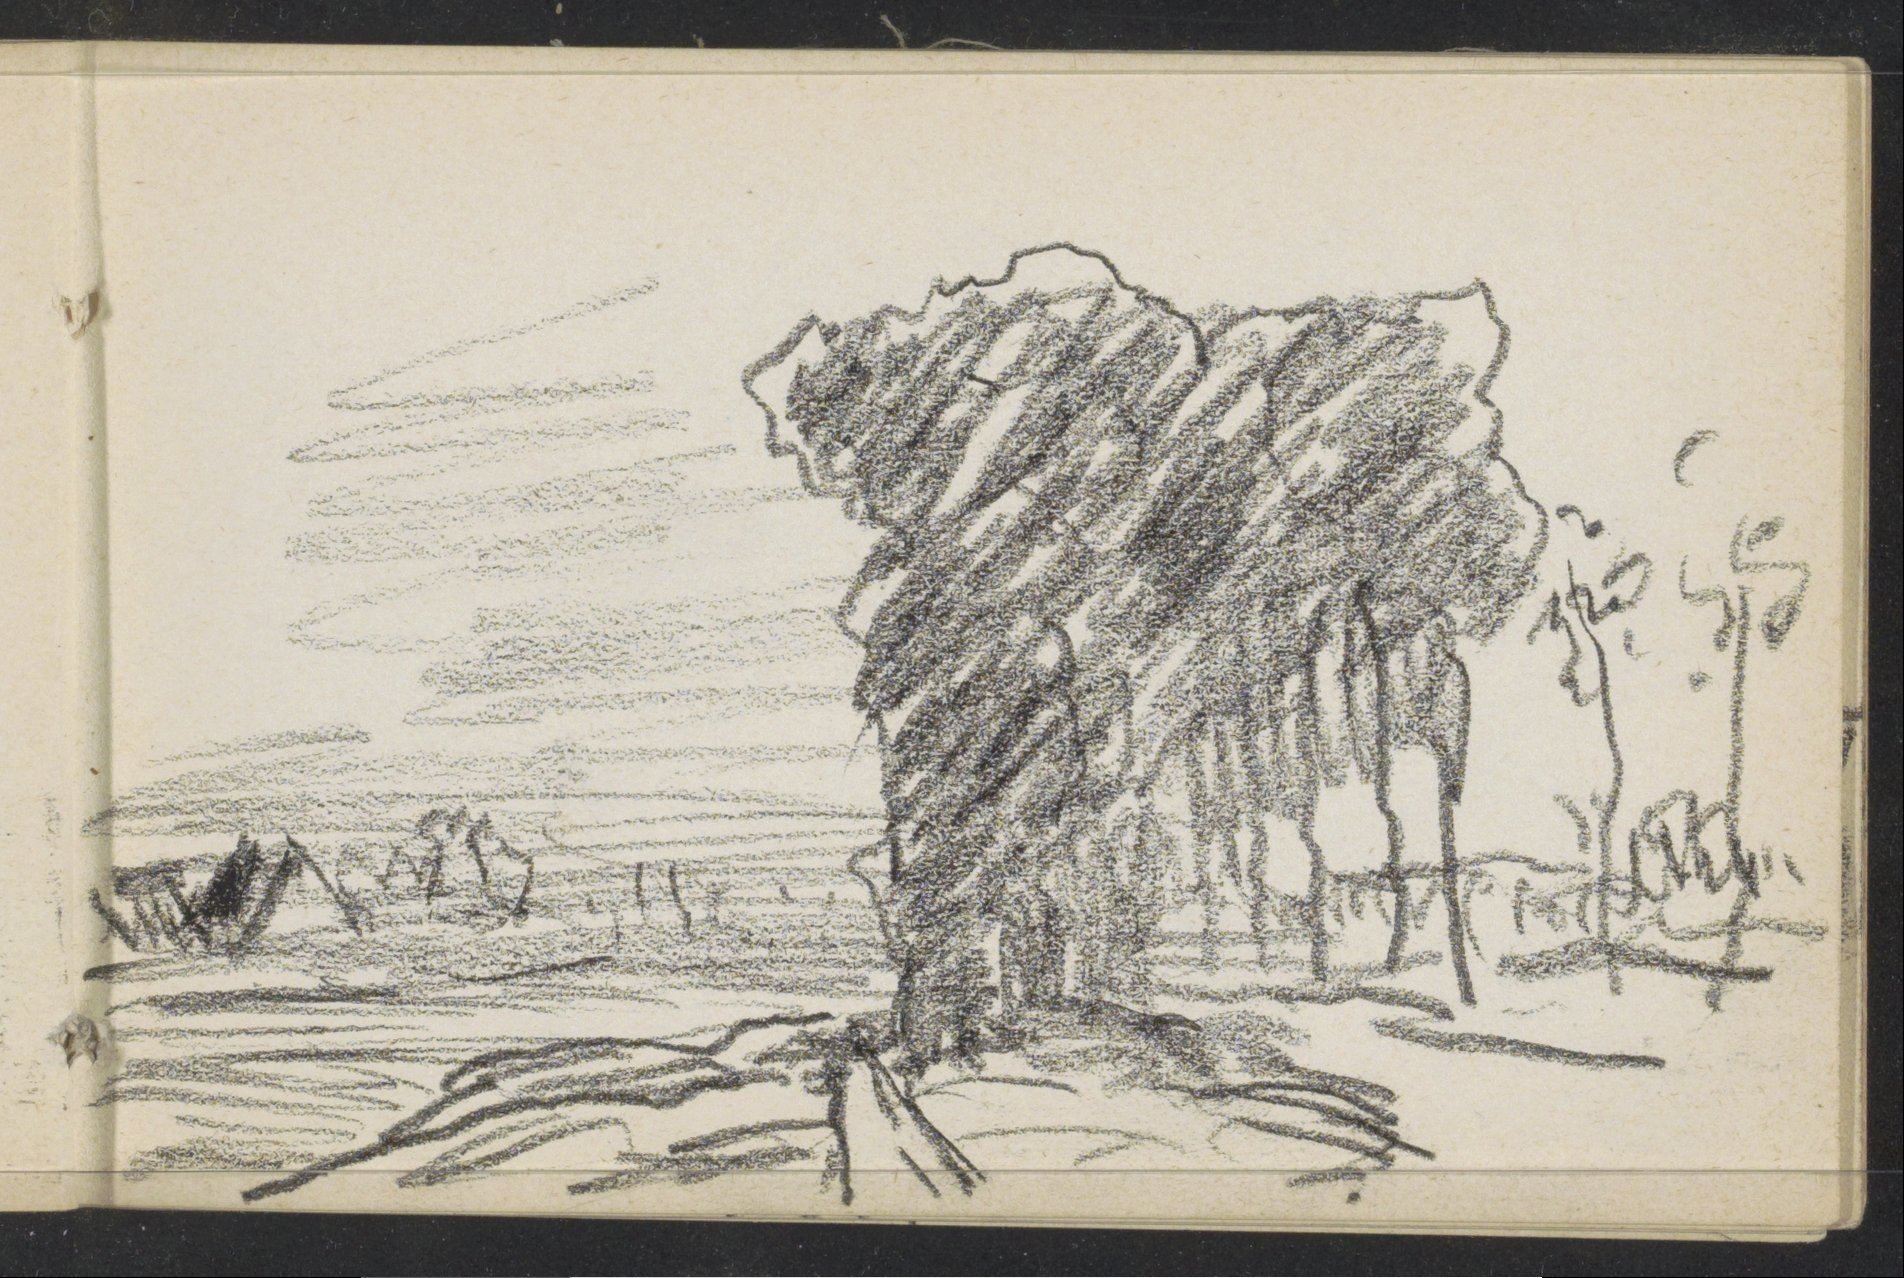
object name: sketchbook leaf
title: Landschap met bomen en bebouwing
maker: alexander shilling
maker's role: draughtsman, print maker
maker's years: 1859-1937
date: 1910-1923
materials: chalk, paper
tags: city-view, and landscape with man-made constructions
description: Blad 11 recto uit een schetsboek met 26 bladen.